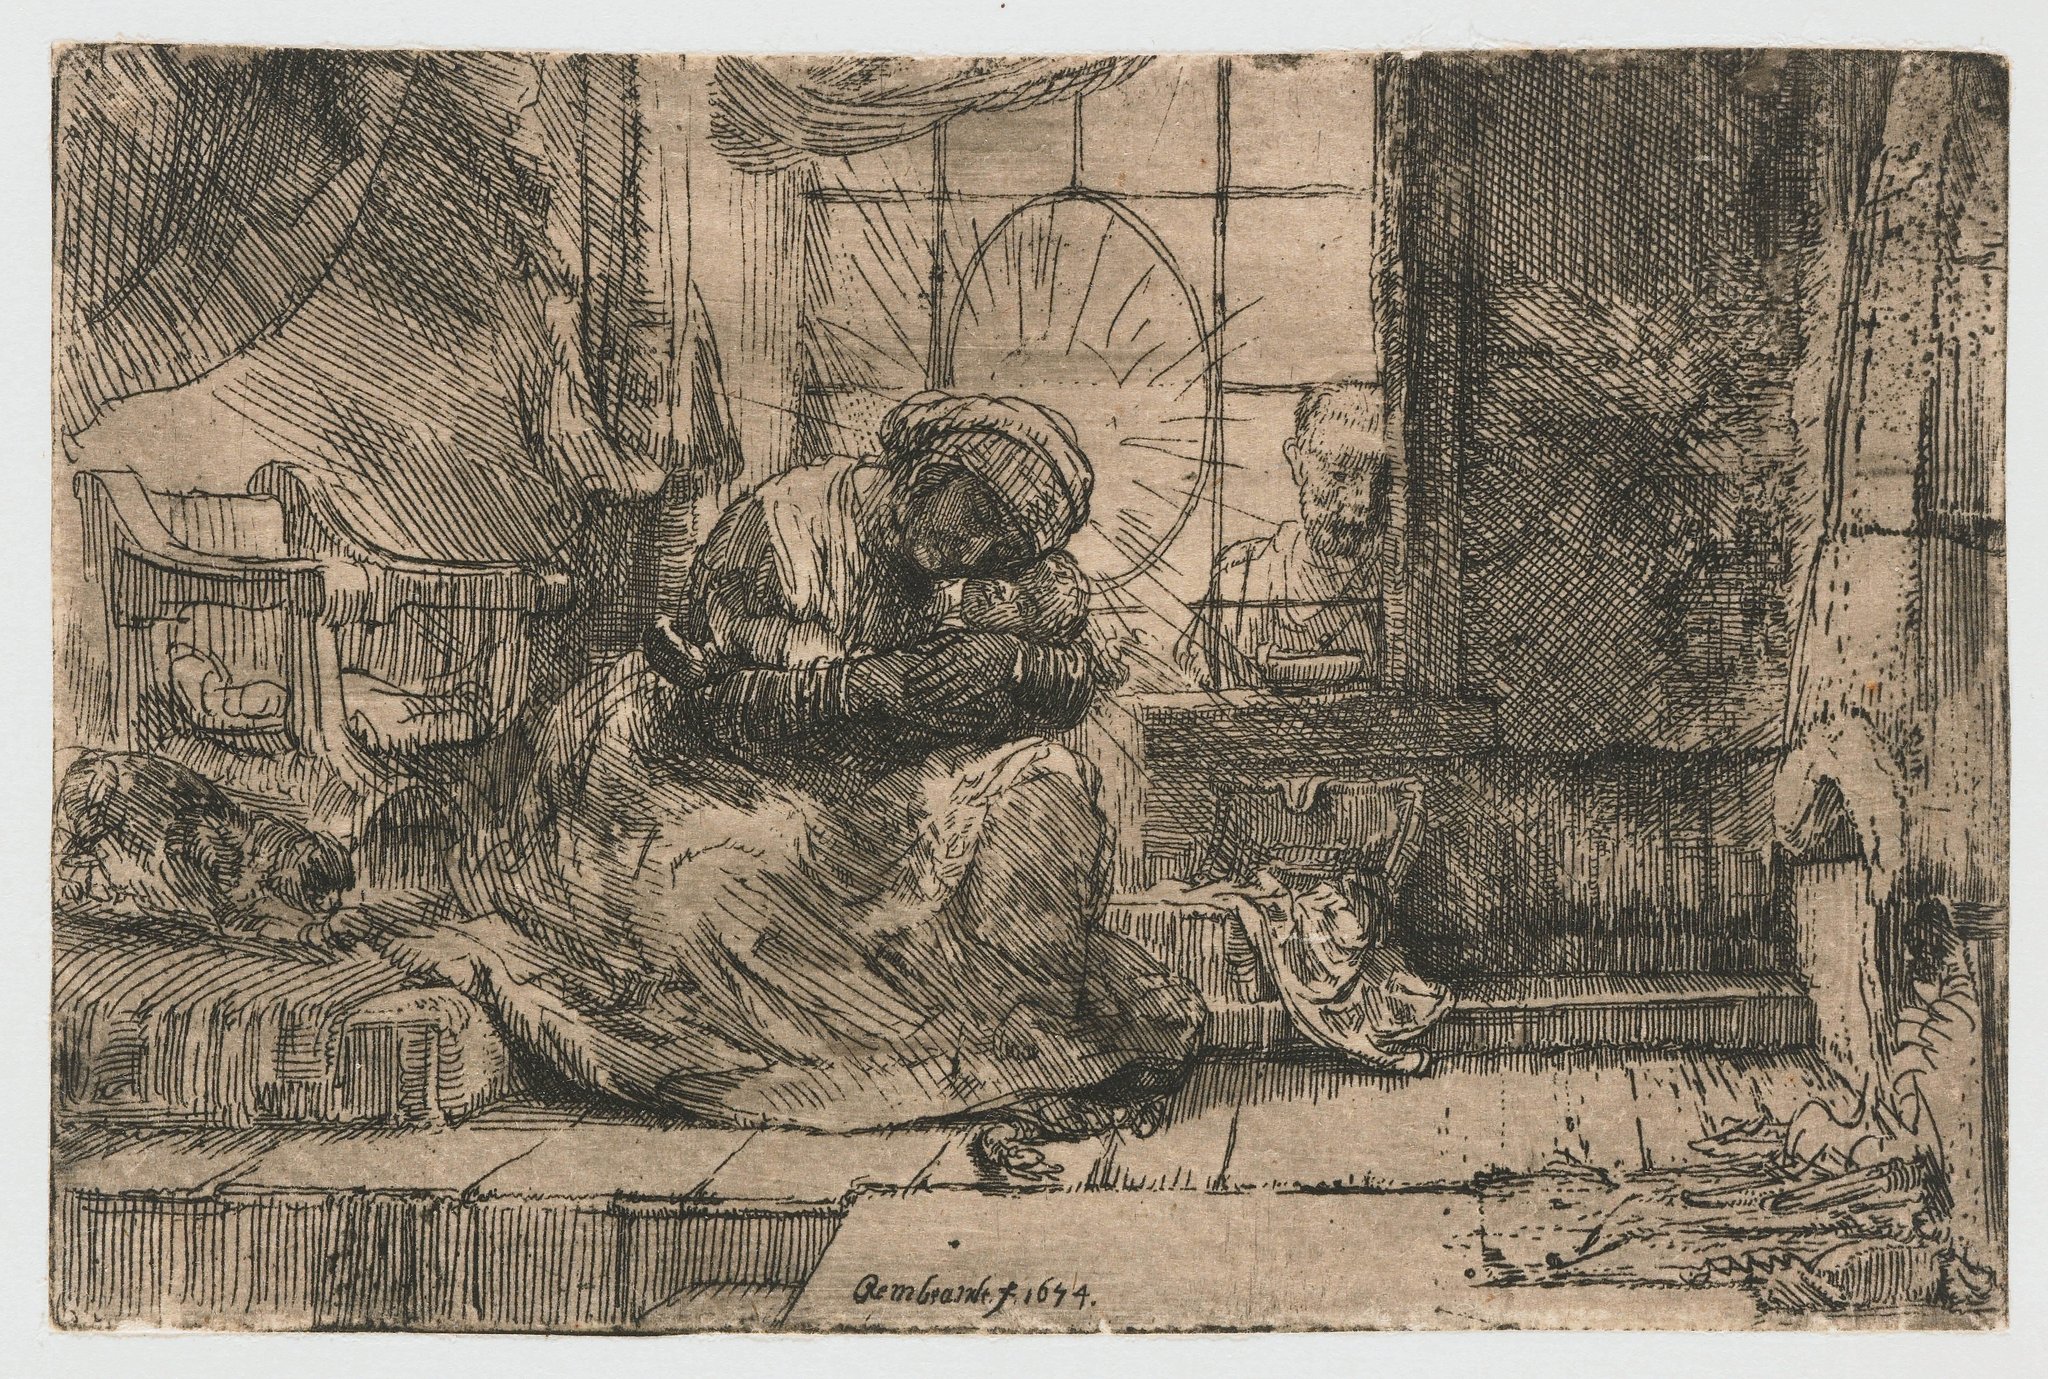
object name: print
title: The Virgin and Child with the cat and the snake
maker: rembrandt van rijn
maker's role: draughtsman, painter, print maker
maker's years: 1606-1669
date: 1654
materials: paper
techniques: etching, intaglio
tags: madonna: mary sitting on the ground, the christ-child in her lap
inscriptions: collector's mark: Lugt 240, signature and date: ‘Rembrandt.f.1654’